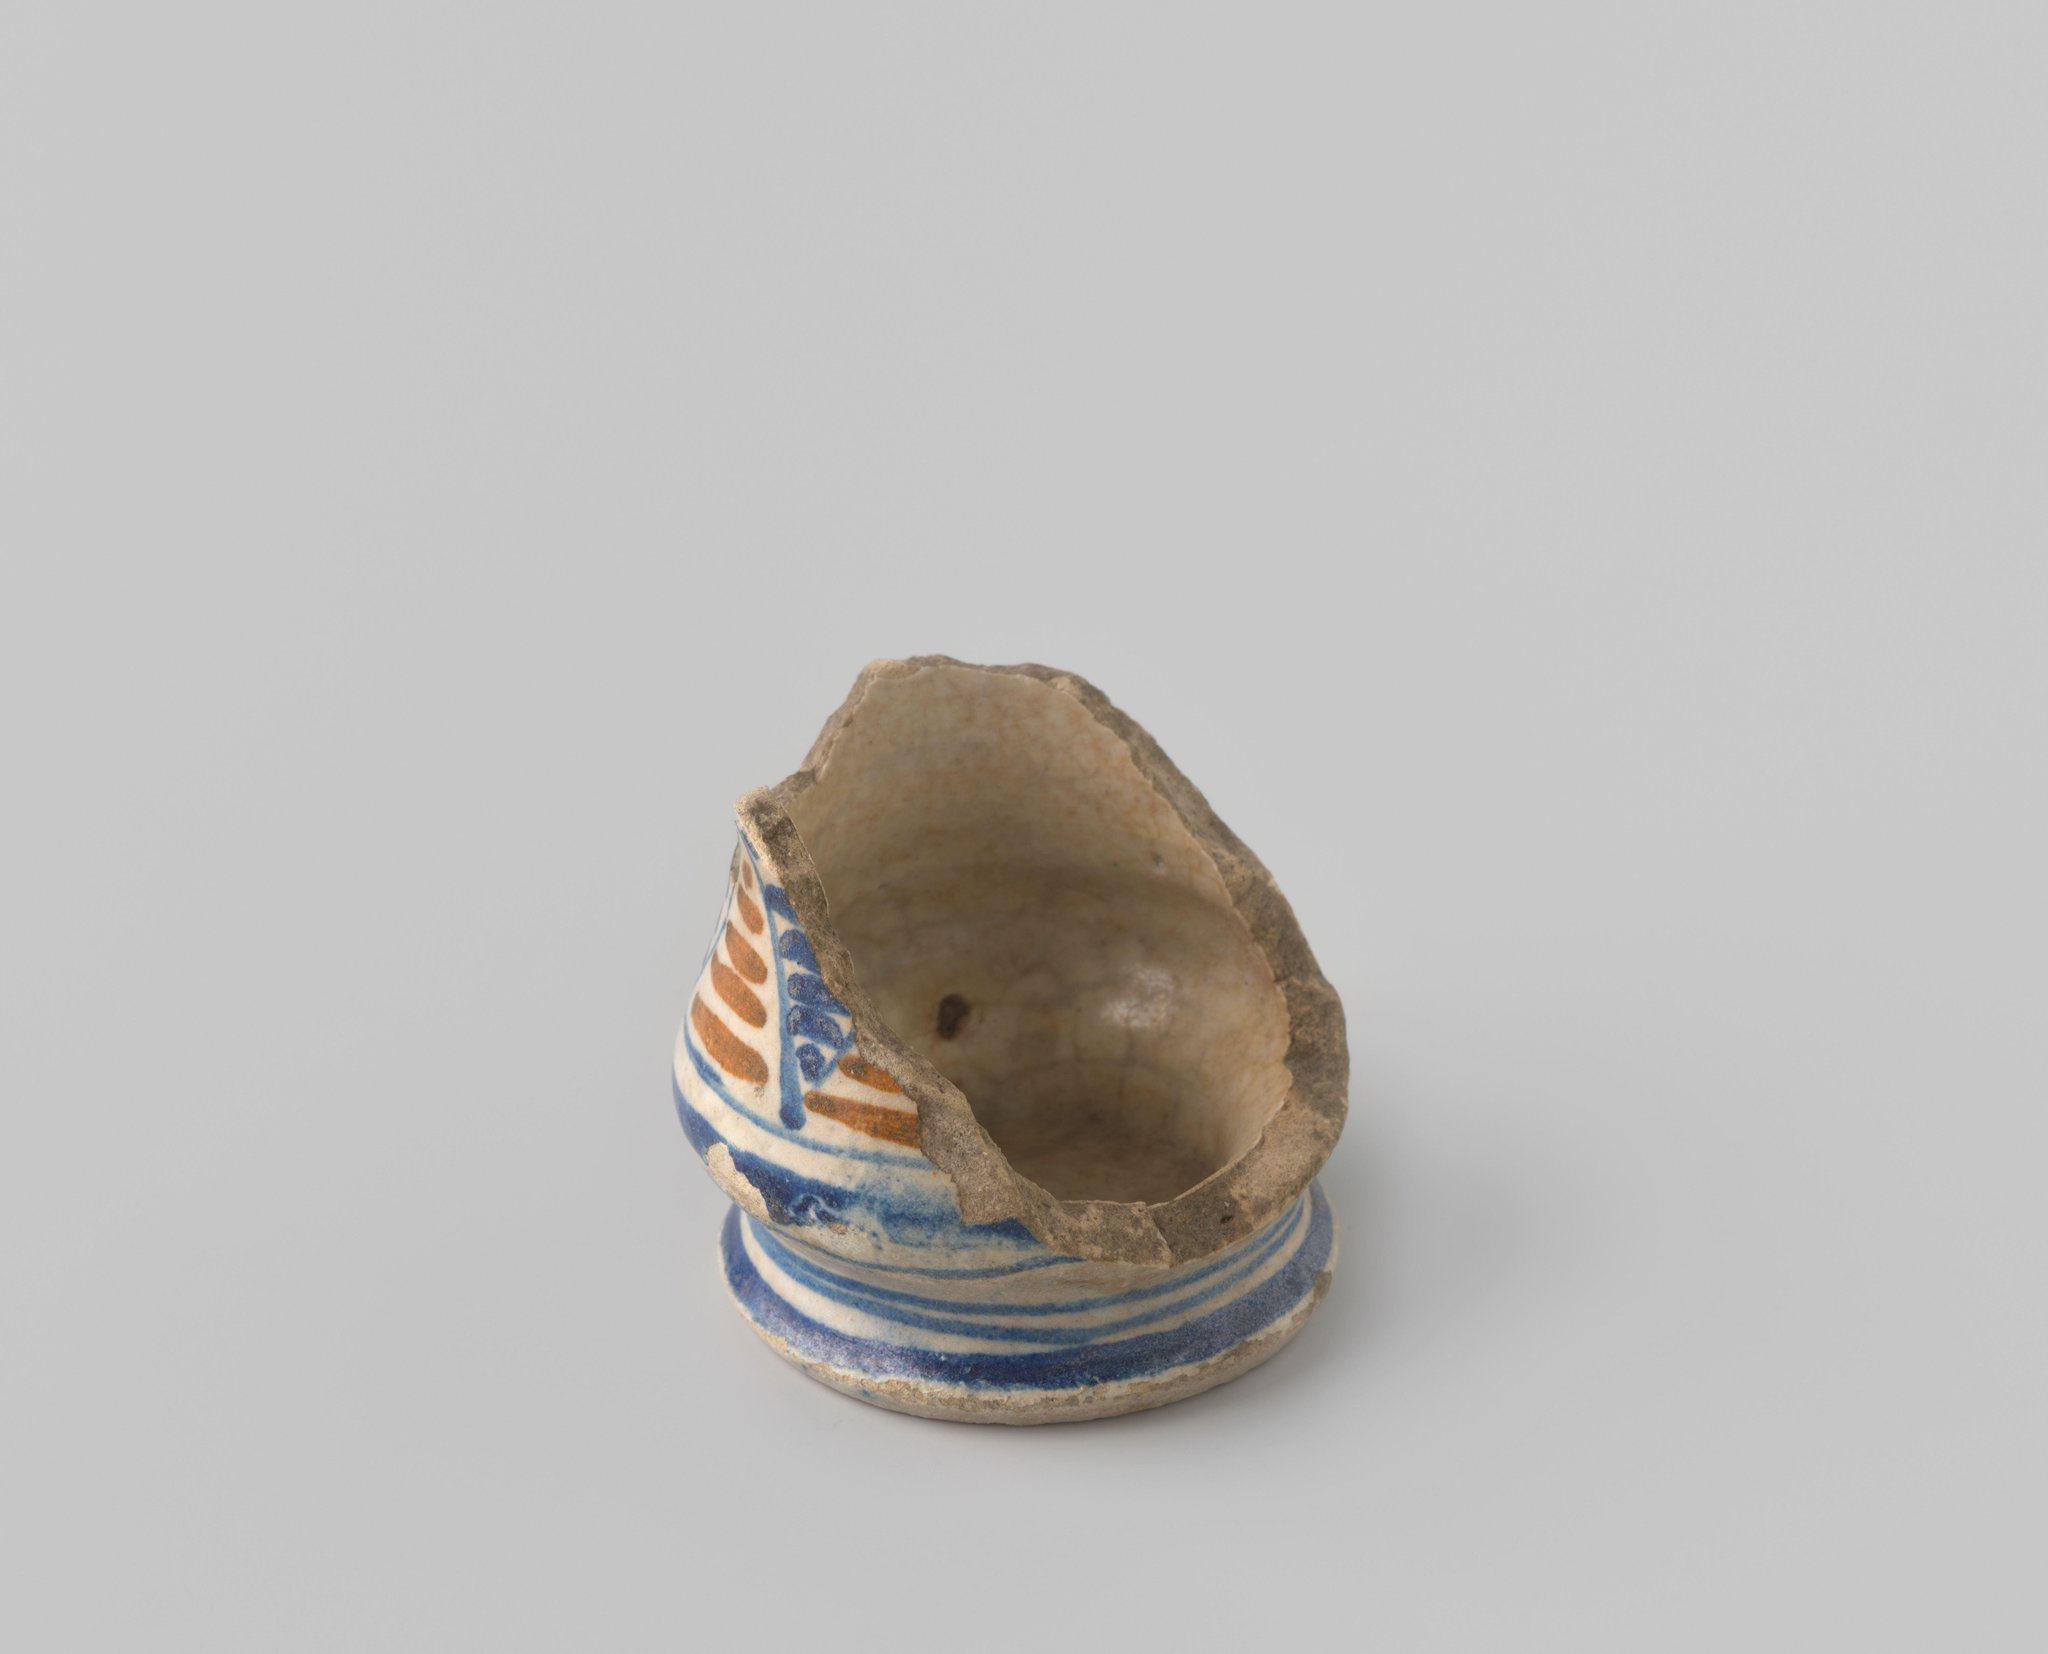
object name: fragment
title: Fragment van een apothekerspot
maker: Anonymous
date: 1500-1600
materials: earthenware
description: Fragment van een apothekerspot, versierd met blauwe ringen om de voet en met een décor van blauwe zigzag lijnen, waartussen dwarsstrepen, afwisselend in blauw en geel. De onderkant zonder glazuur. Witte aarde. Binnenzijde wit verglaasd. Opmerking: gevonden op de plaats waar eertijds het ziekenhuis van de Praemontratenser abdij te Middelburg was, dus voor 1570 (in dat jaar werd de abdij opgeheven).